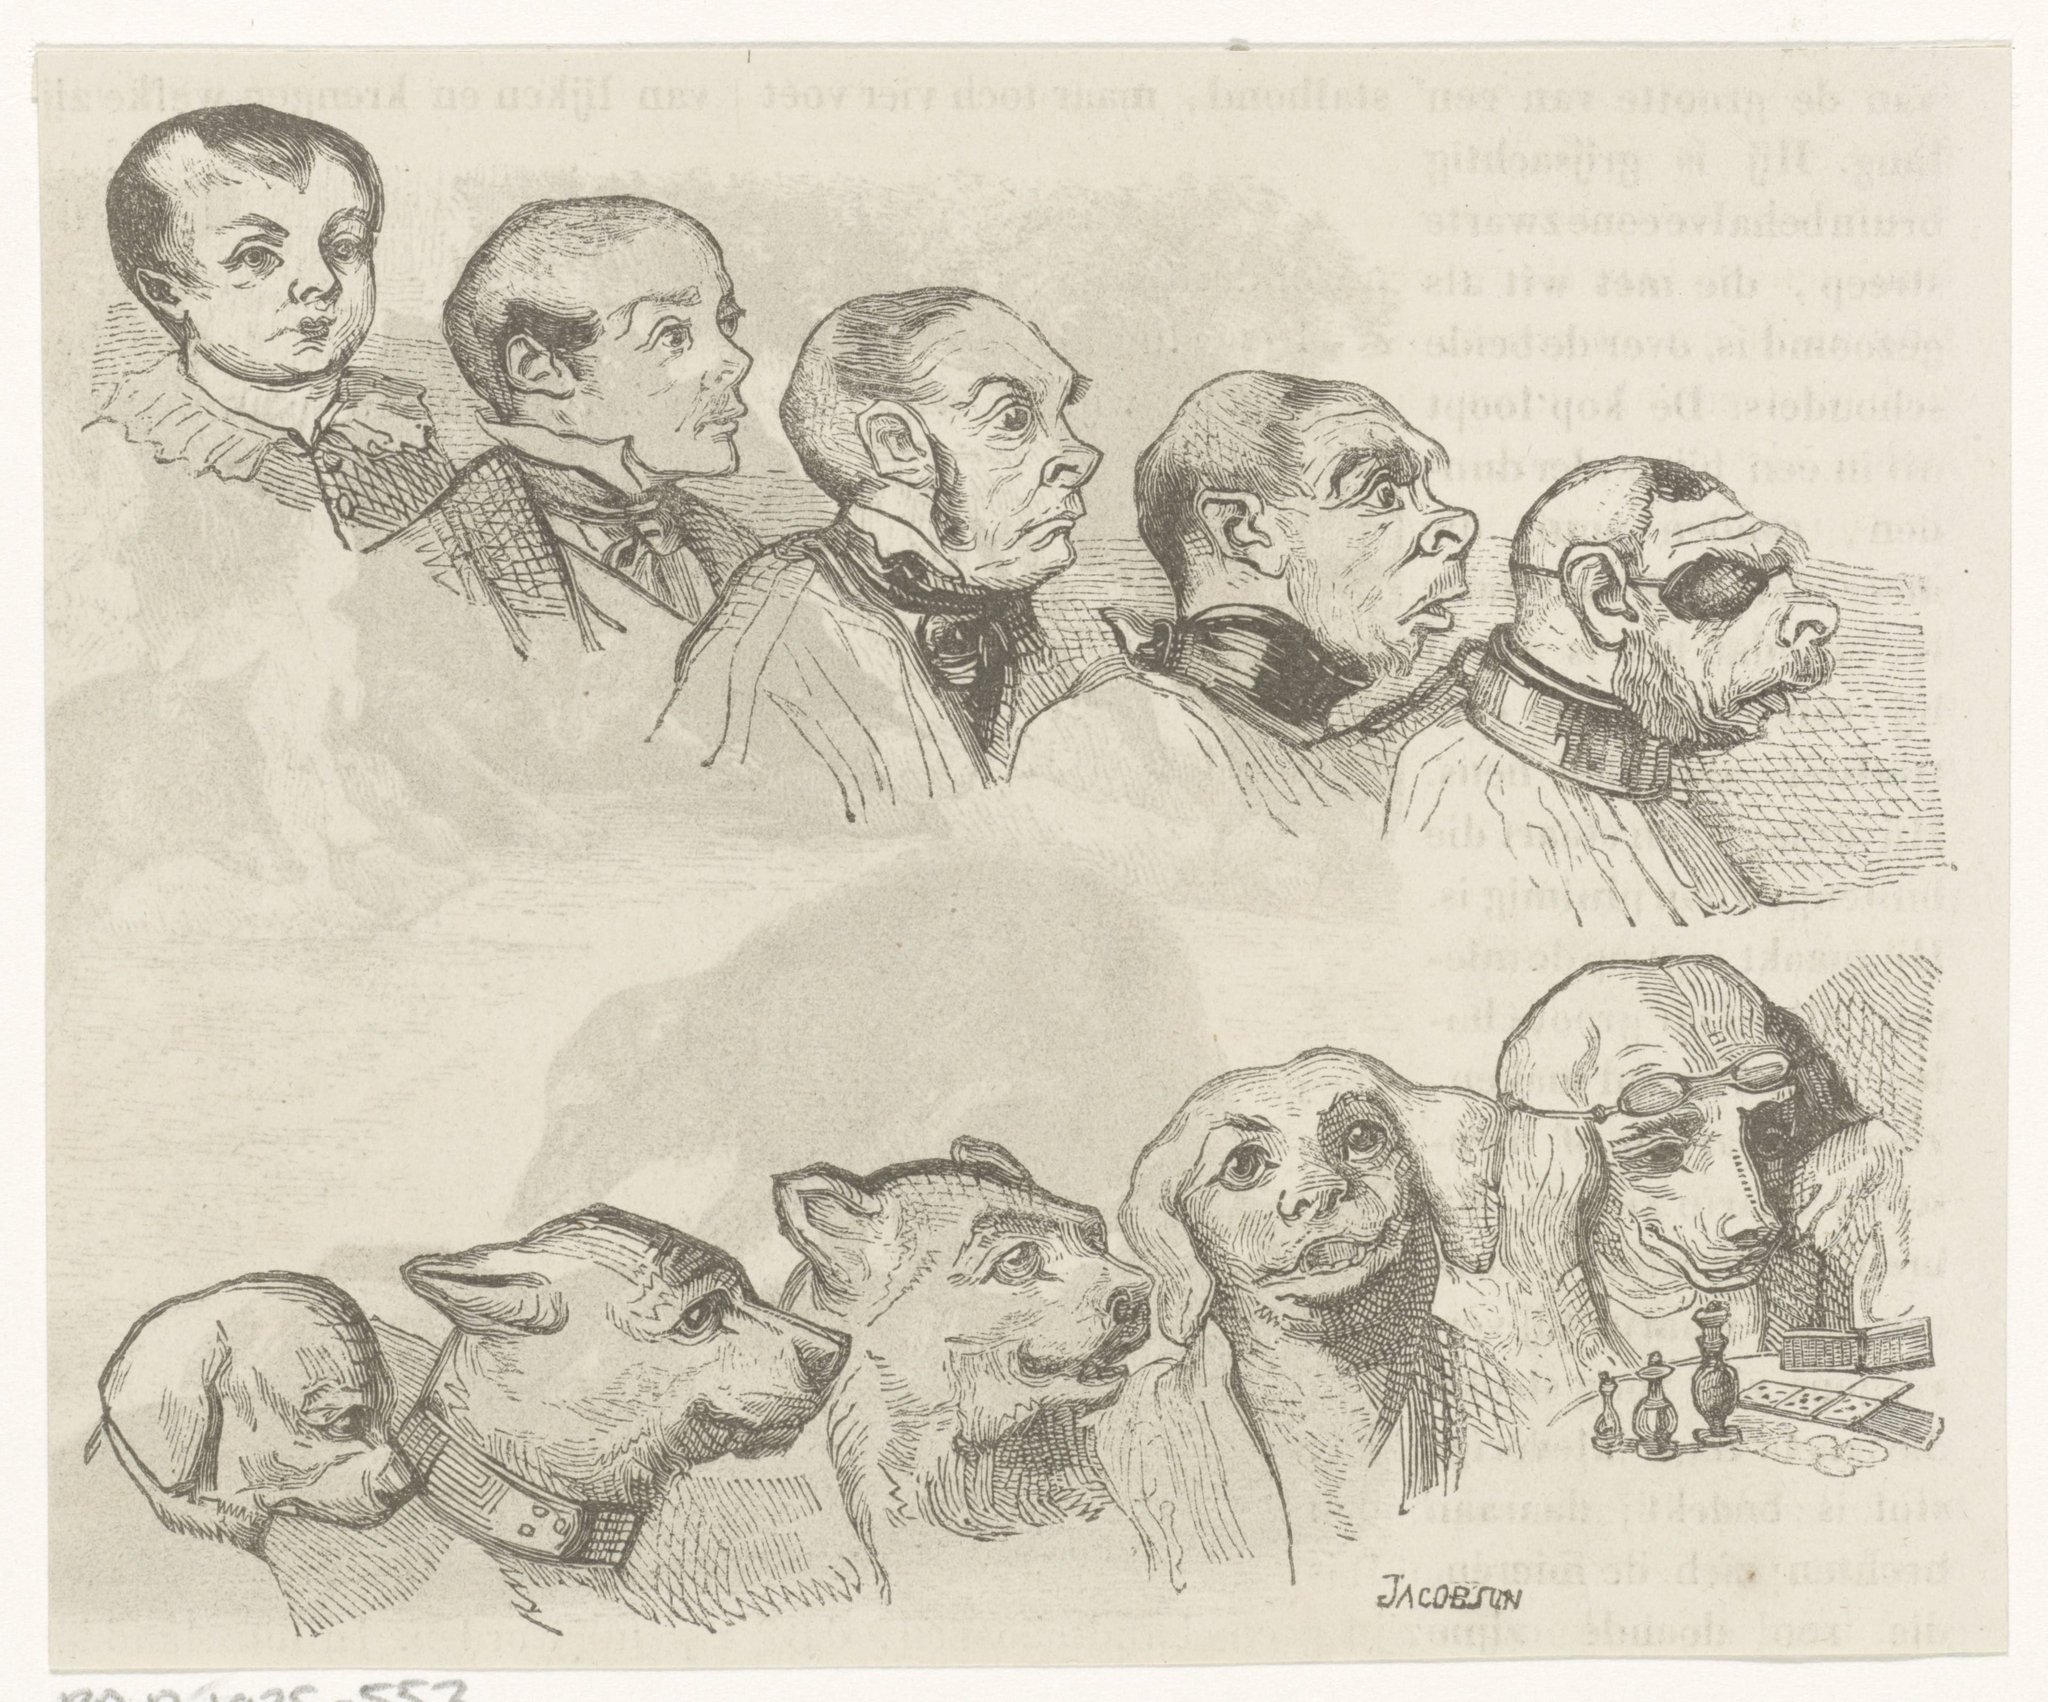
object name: print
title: Mensenhoofd metamorfoserend in een hondenkop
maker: desiré nathan jacobson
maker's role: print maker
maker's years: 1827-1846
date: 1837-1927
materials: paper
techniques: letterpress printing, engraving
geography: the hague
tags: man and animal, human being, man in general, dog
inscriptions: collector's mark: Lugt 2760